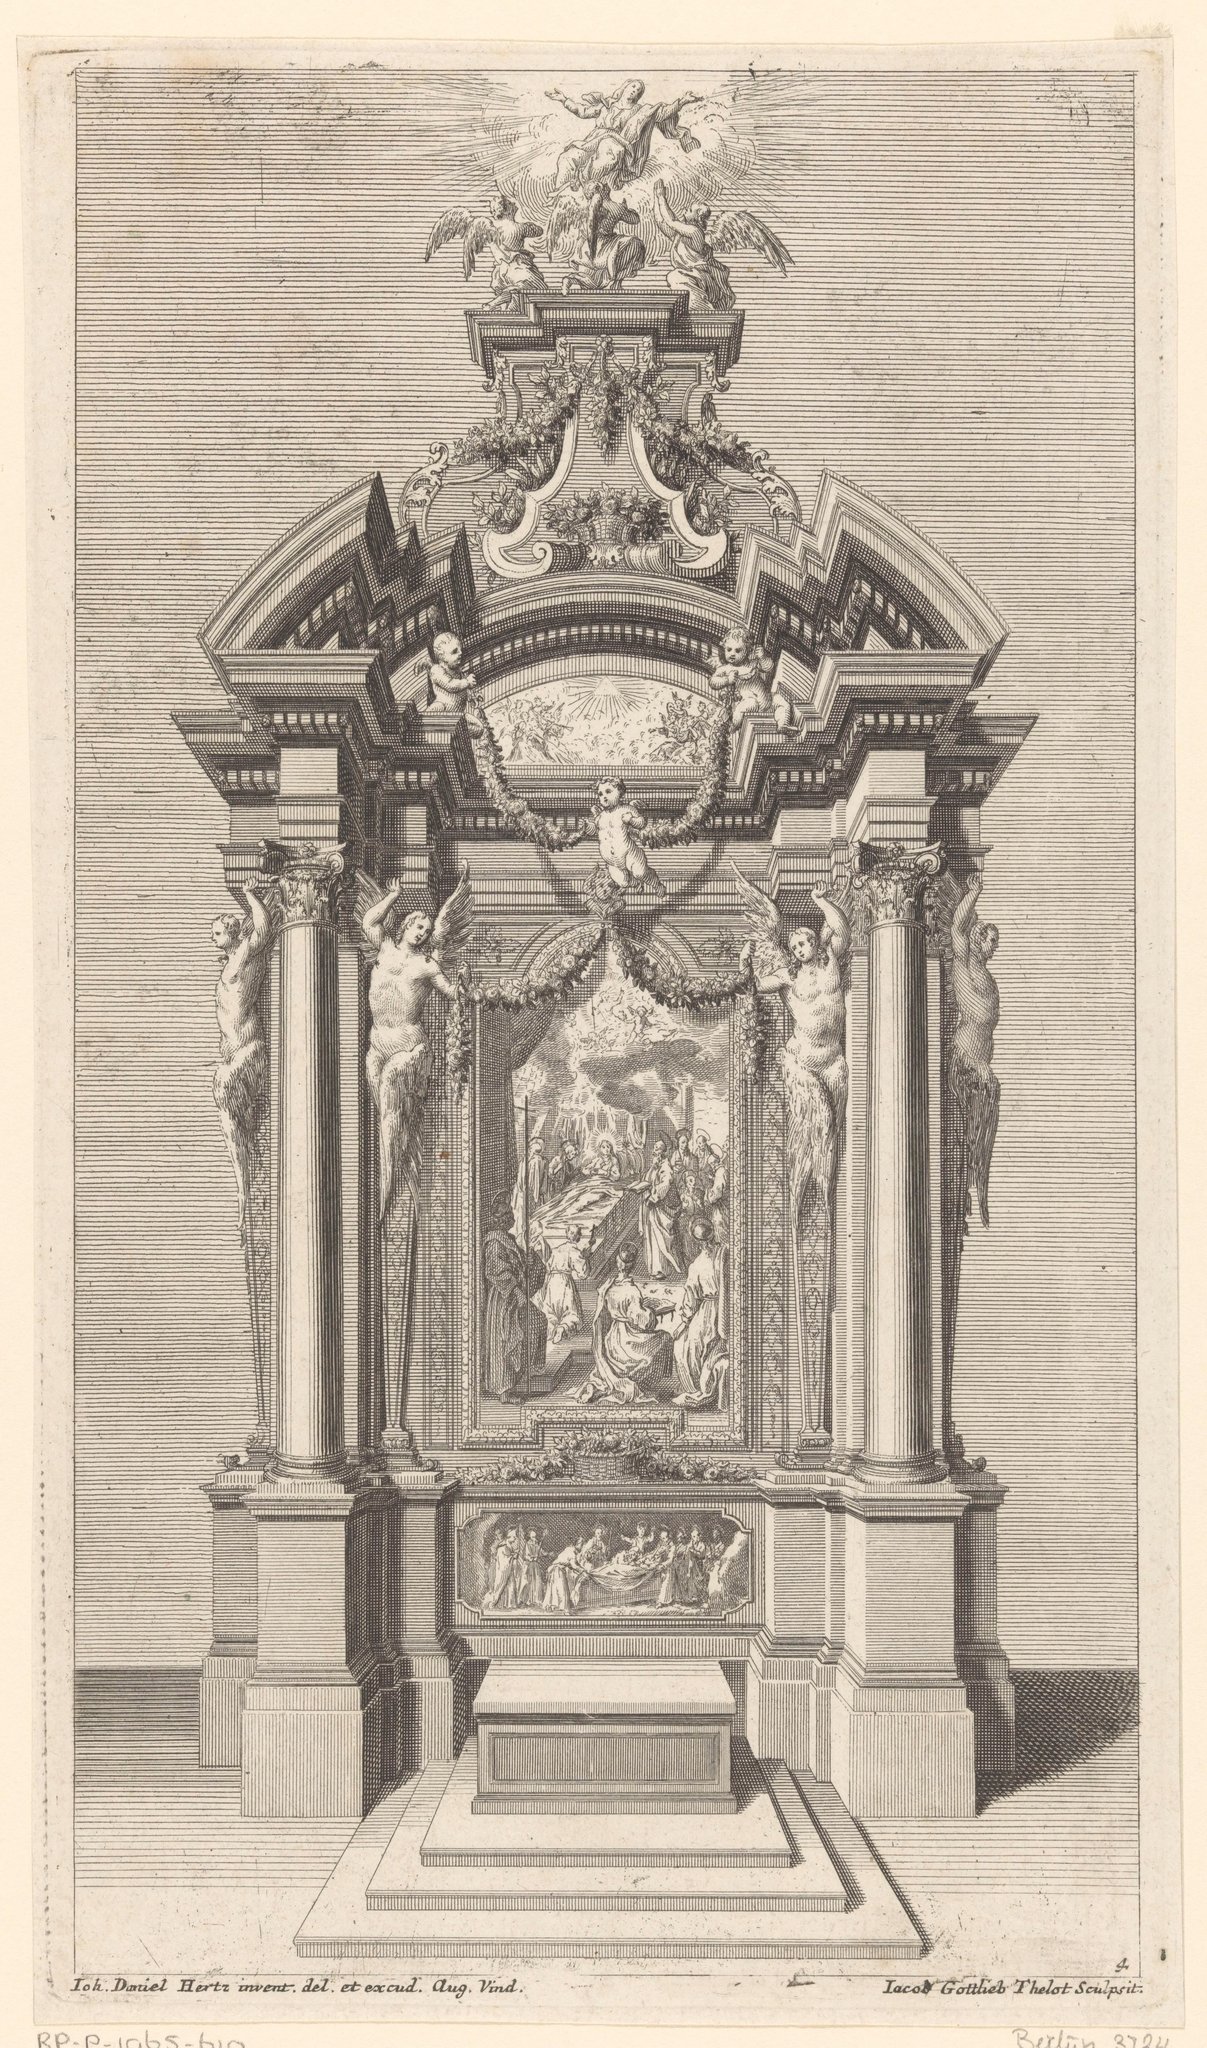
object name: print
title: Altaren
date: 1722-1740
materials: paper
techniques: engraving, etching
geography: augsburg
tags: the dormition: mary on her deathbed; the apostles are gathered around her (john the evangelist may be shown sleeping or dreaming), the assumption of mary ('assumptio corporis'): she is borne into heaven by angels, the entombment of mary, altar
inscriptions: collector's mark: Lugt 2228, collector's mark: Lugt 2760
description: Ontwerp voor een altaar met een beschildering van Maria op haar sterfbed, omgeven door de apostelen. Daaronder een scène met de graflegging van Maria. Het altaar wordt geflankeerd door vier engelen met vier vleugels. Putti met guirlandes en de hemelvaart van Maria bekronen het geheel.